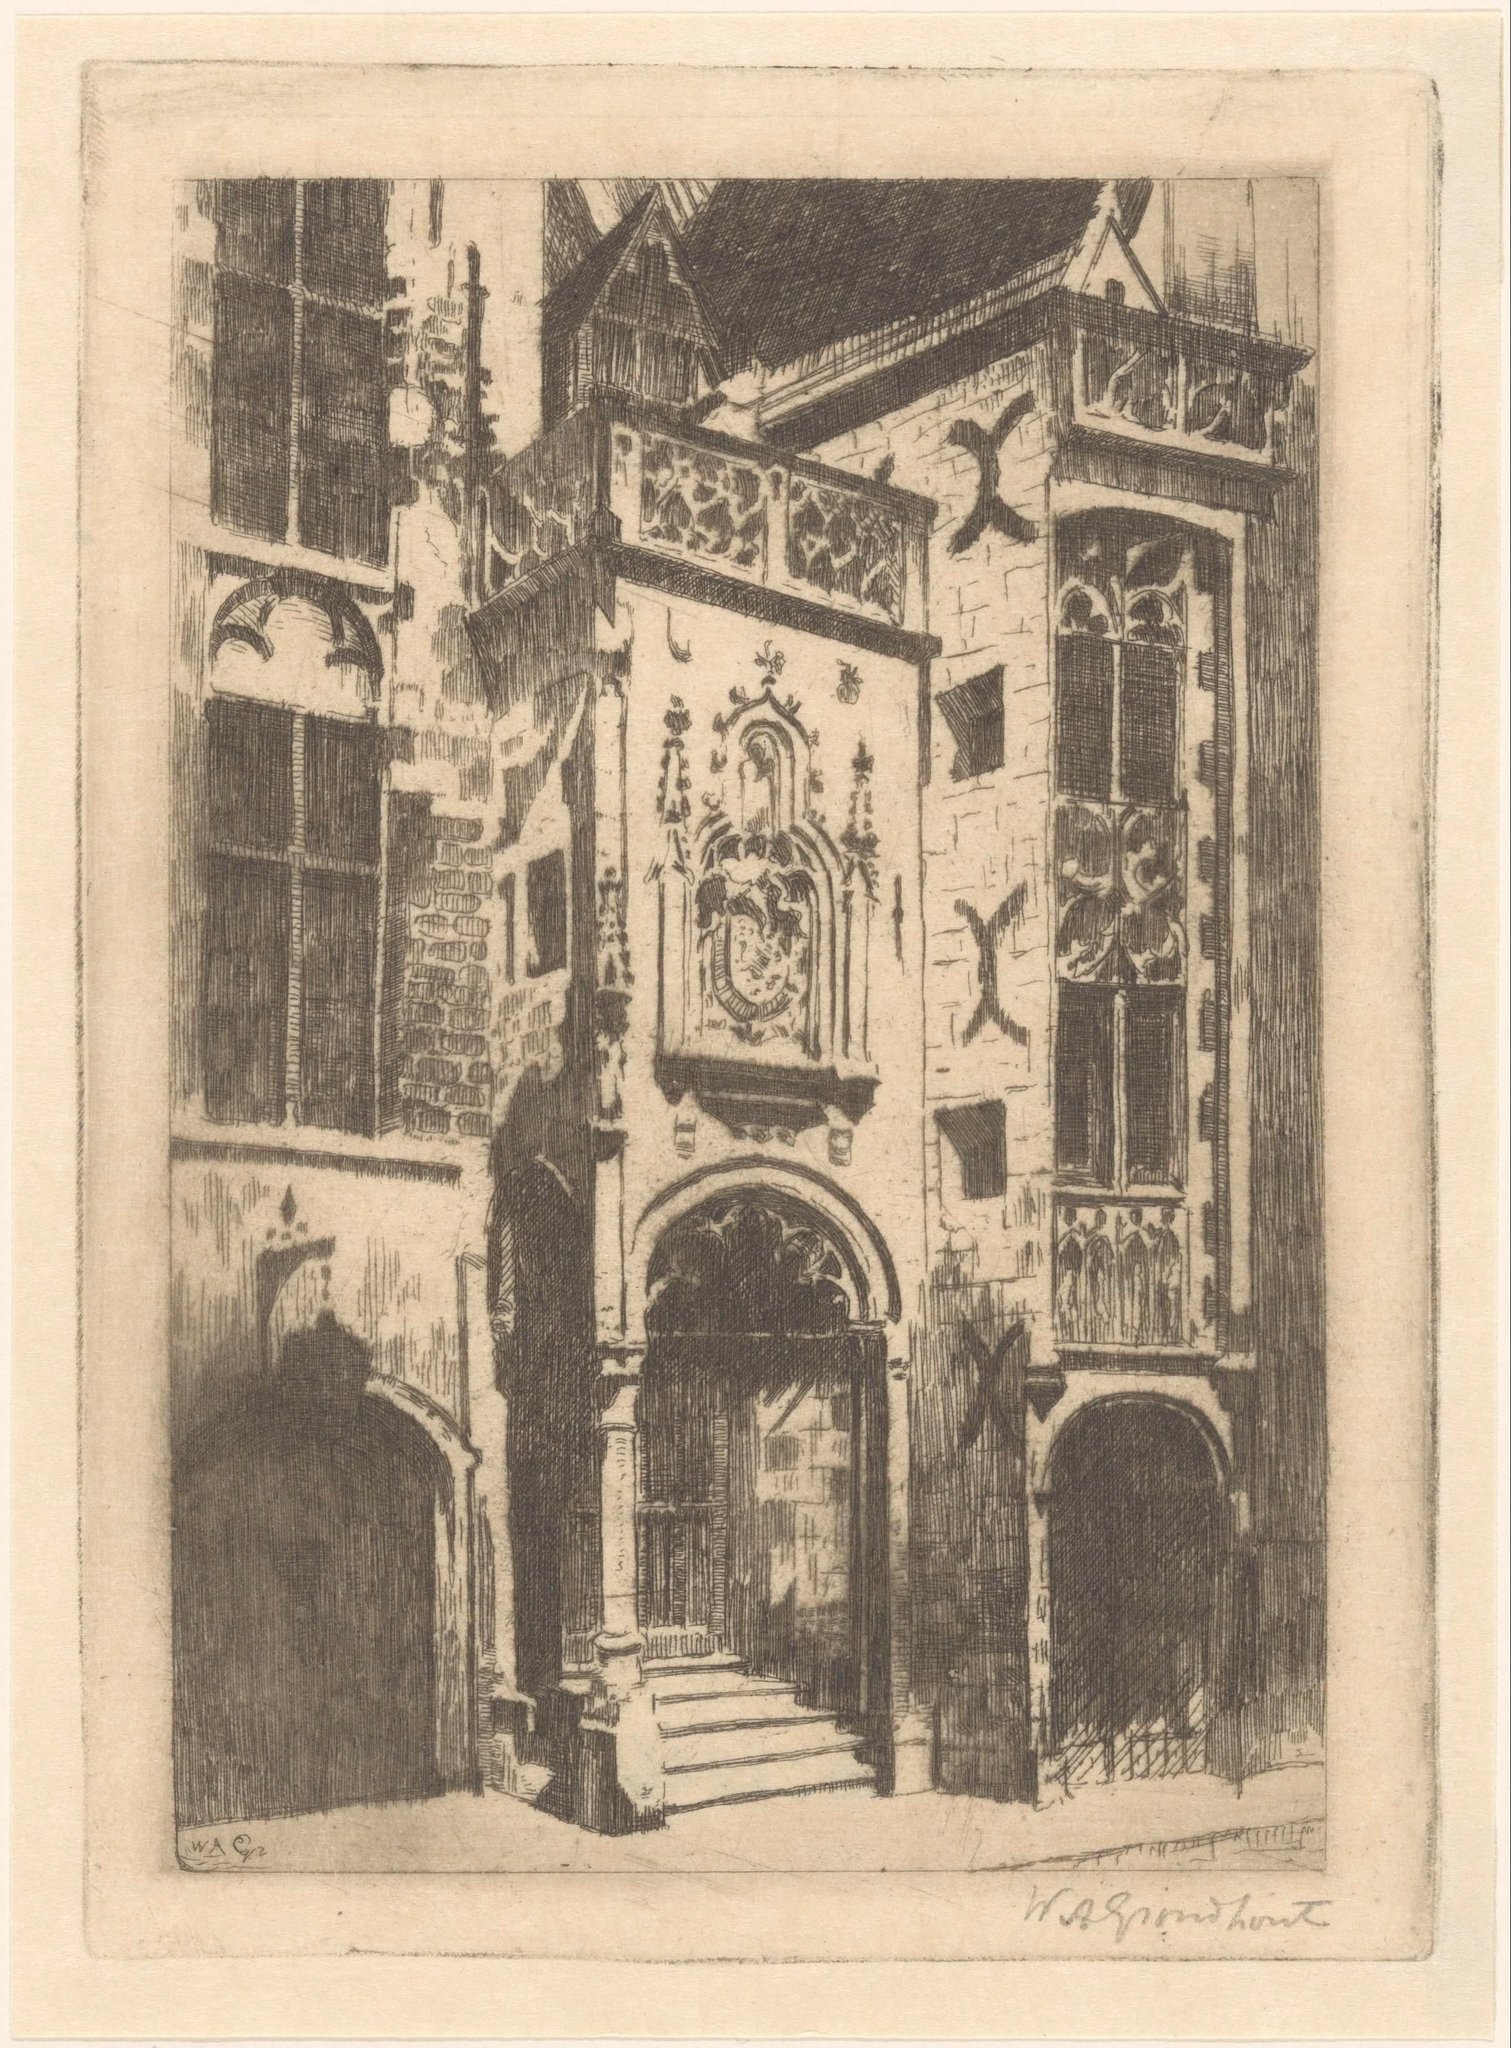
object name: print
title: Brugge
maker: willem adrianus grondhout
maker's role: draughtsman, painter, print maker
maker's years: 1878-1934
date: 1888-1931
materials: paper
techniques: etching, intaglio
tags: windmill, bruges